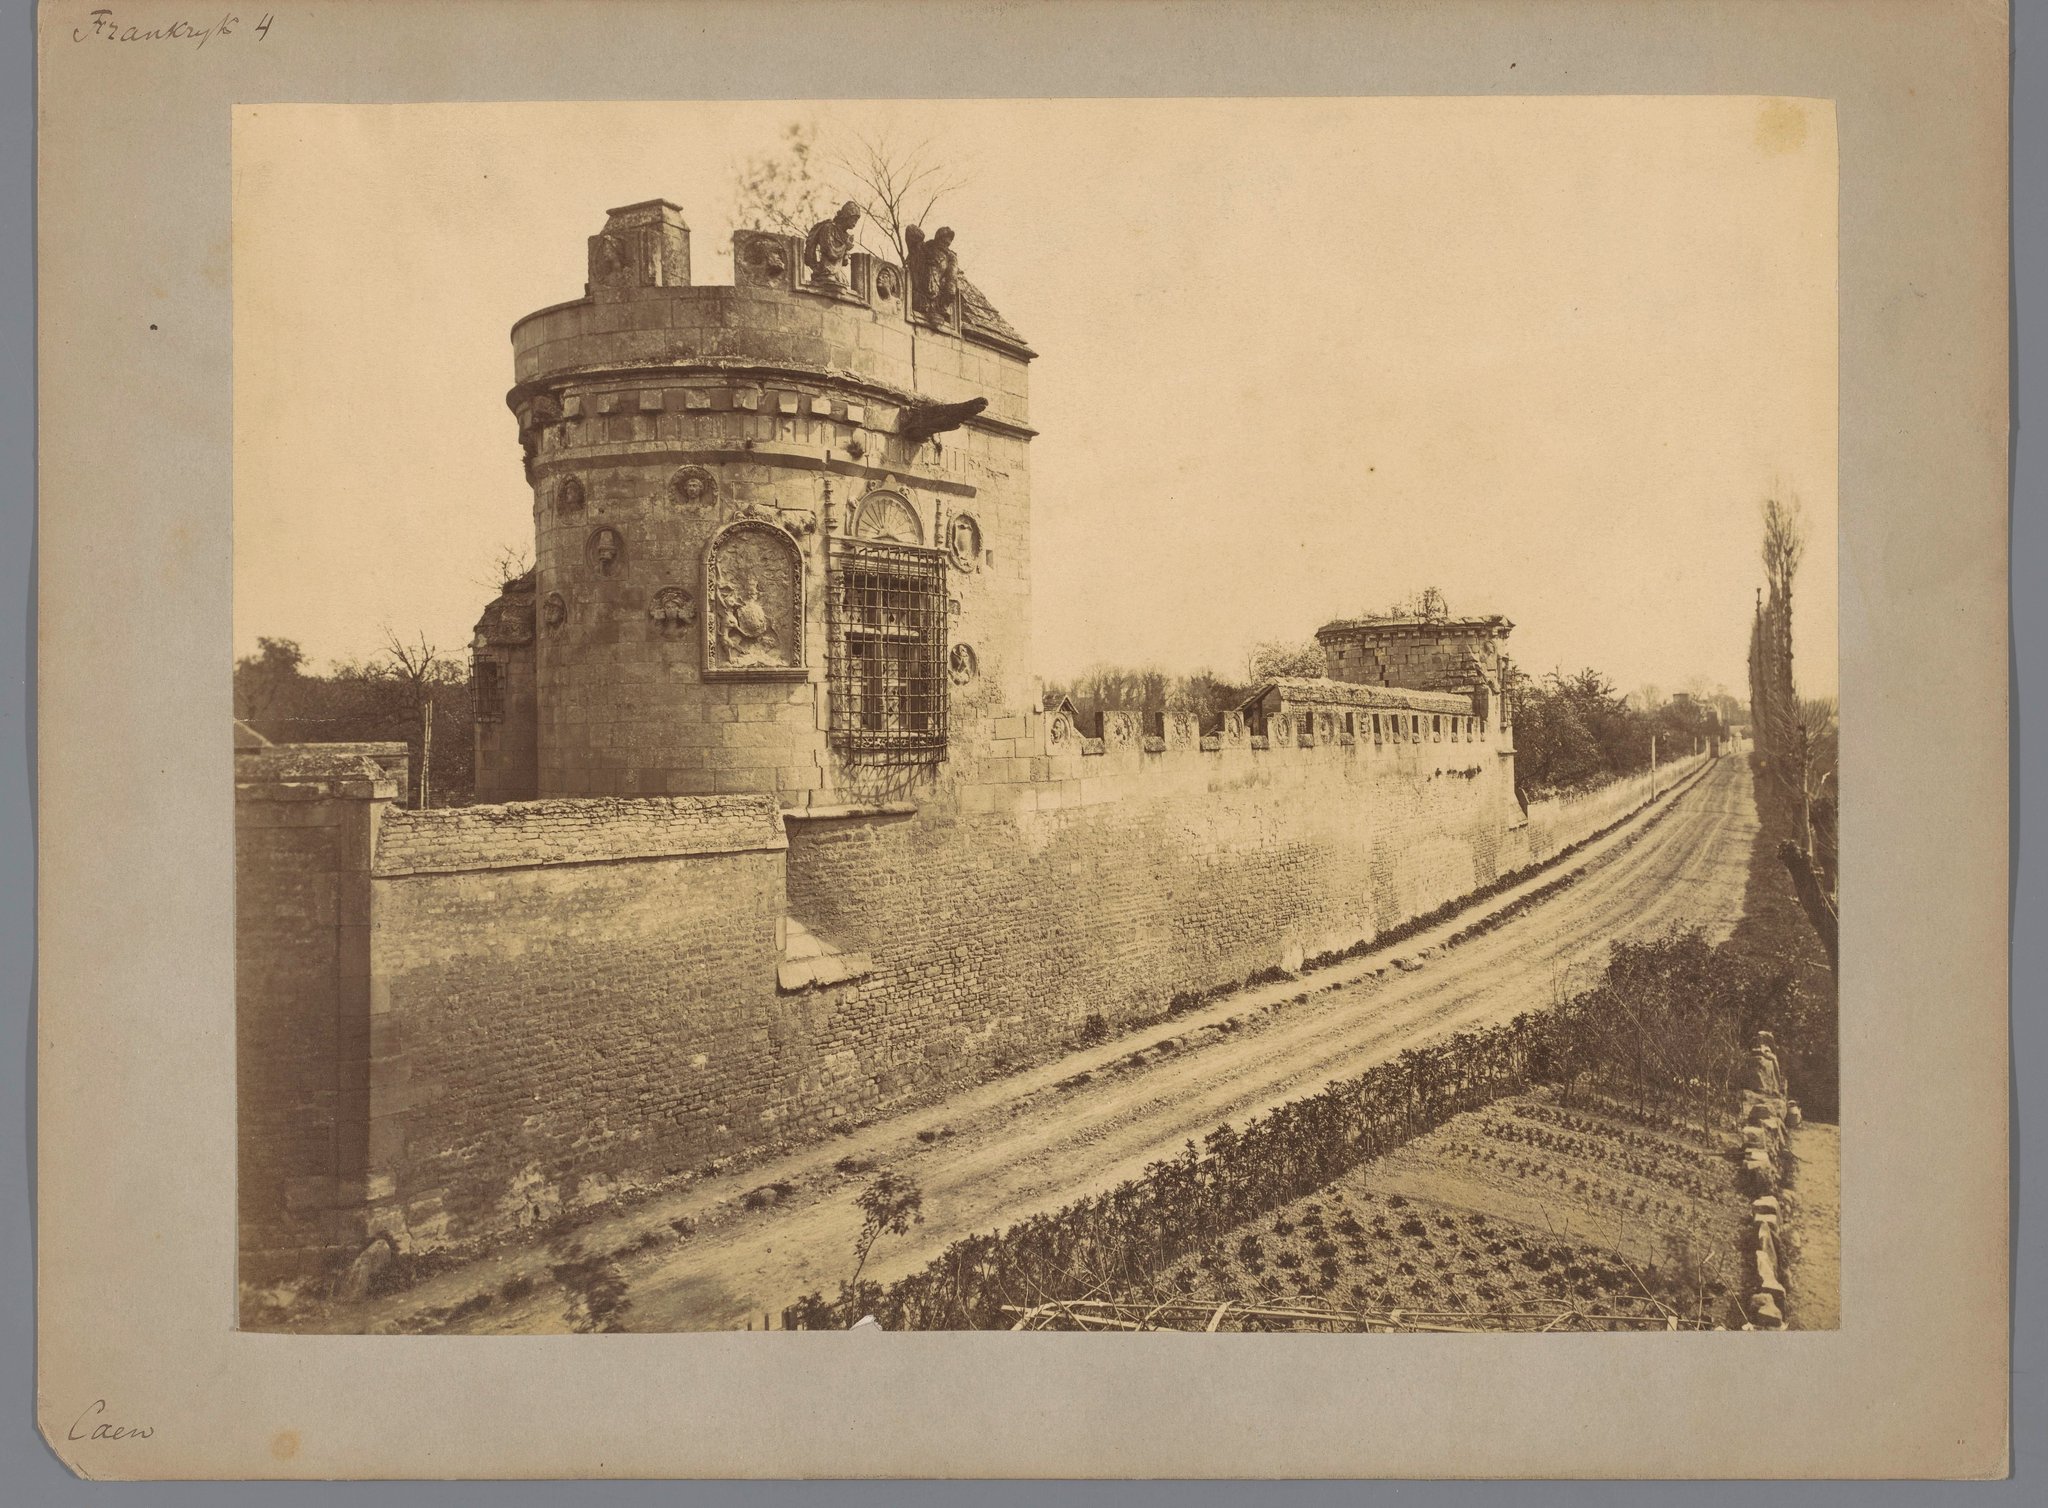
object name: photograph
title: Caen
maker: Anonymous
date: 1850-1900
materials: cardboard, photographic support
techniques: albumen print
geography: caen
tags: landscape with ruins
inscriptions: number: ‘Frankrijk 4’, annotation: ‘Caen’, collector's mark: ‘Rijks-normaalschool voor teekenonderwijzers Amsterdam’ Lugt 3937